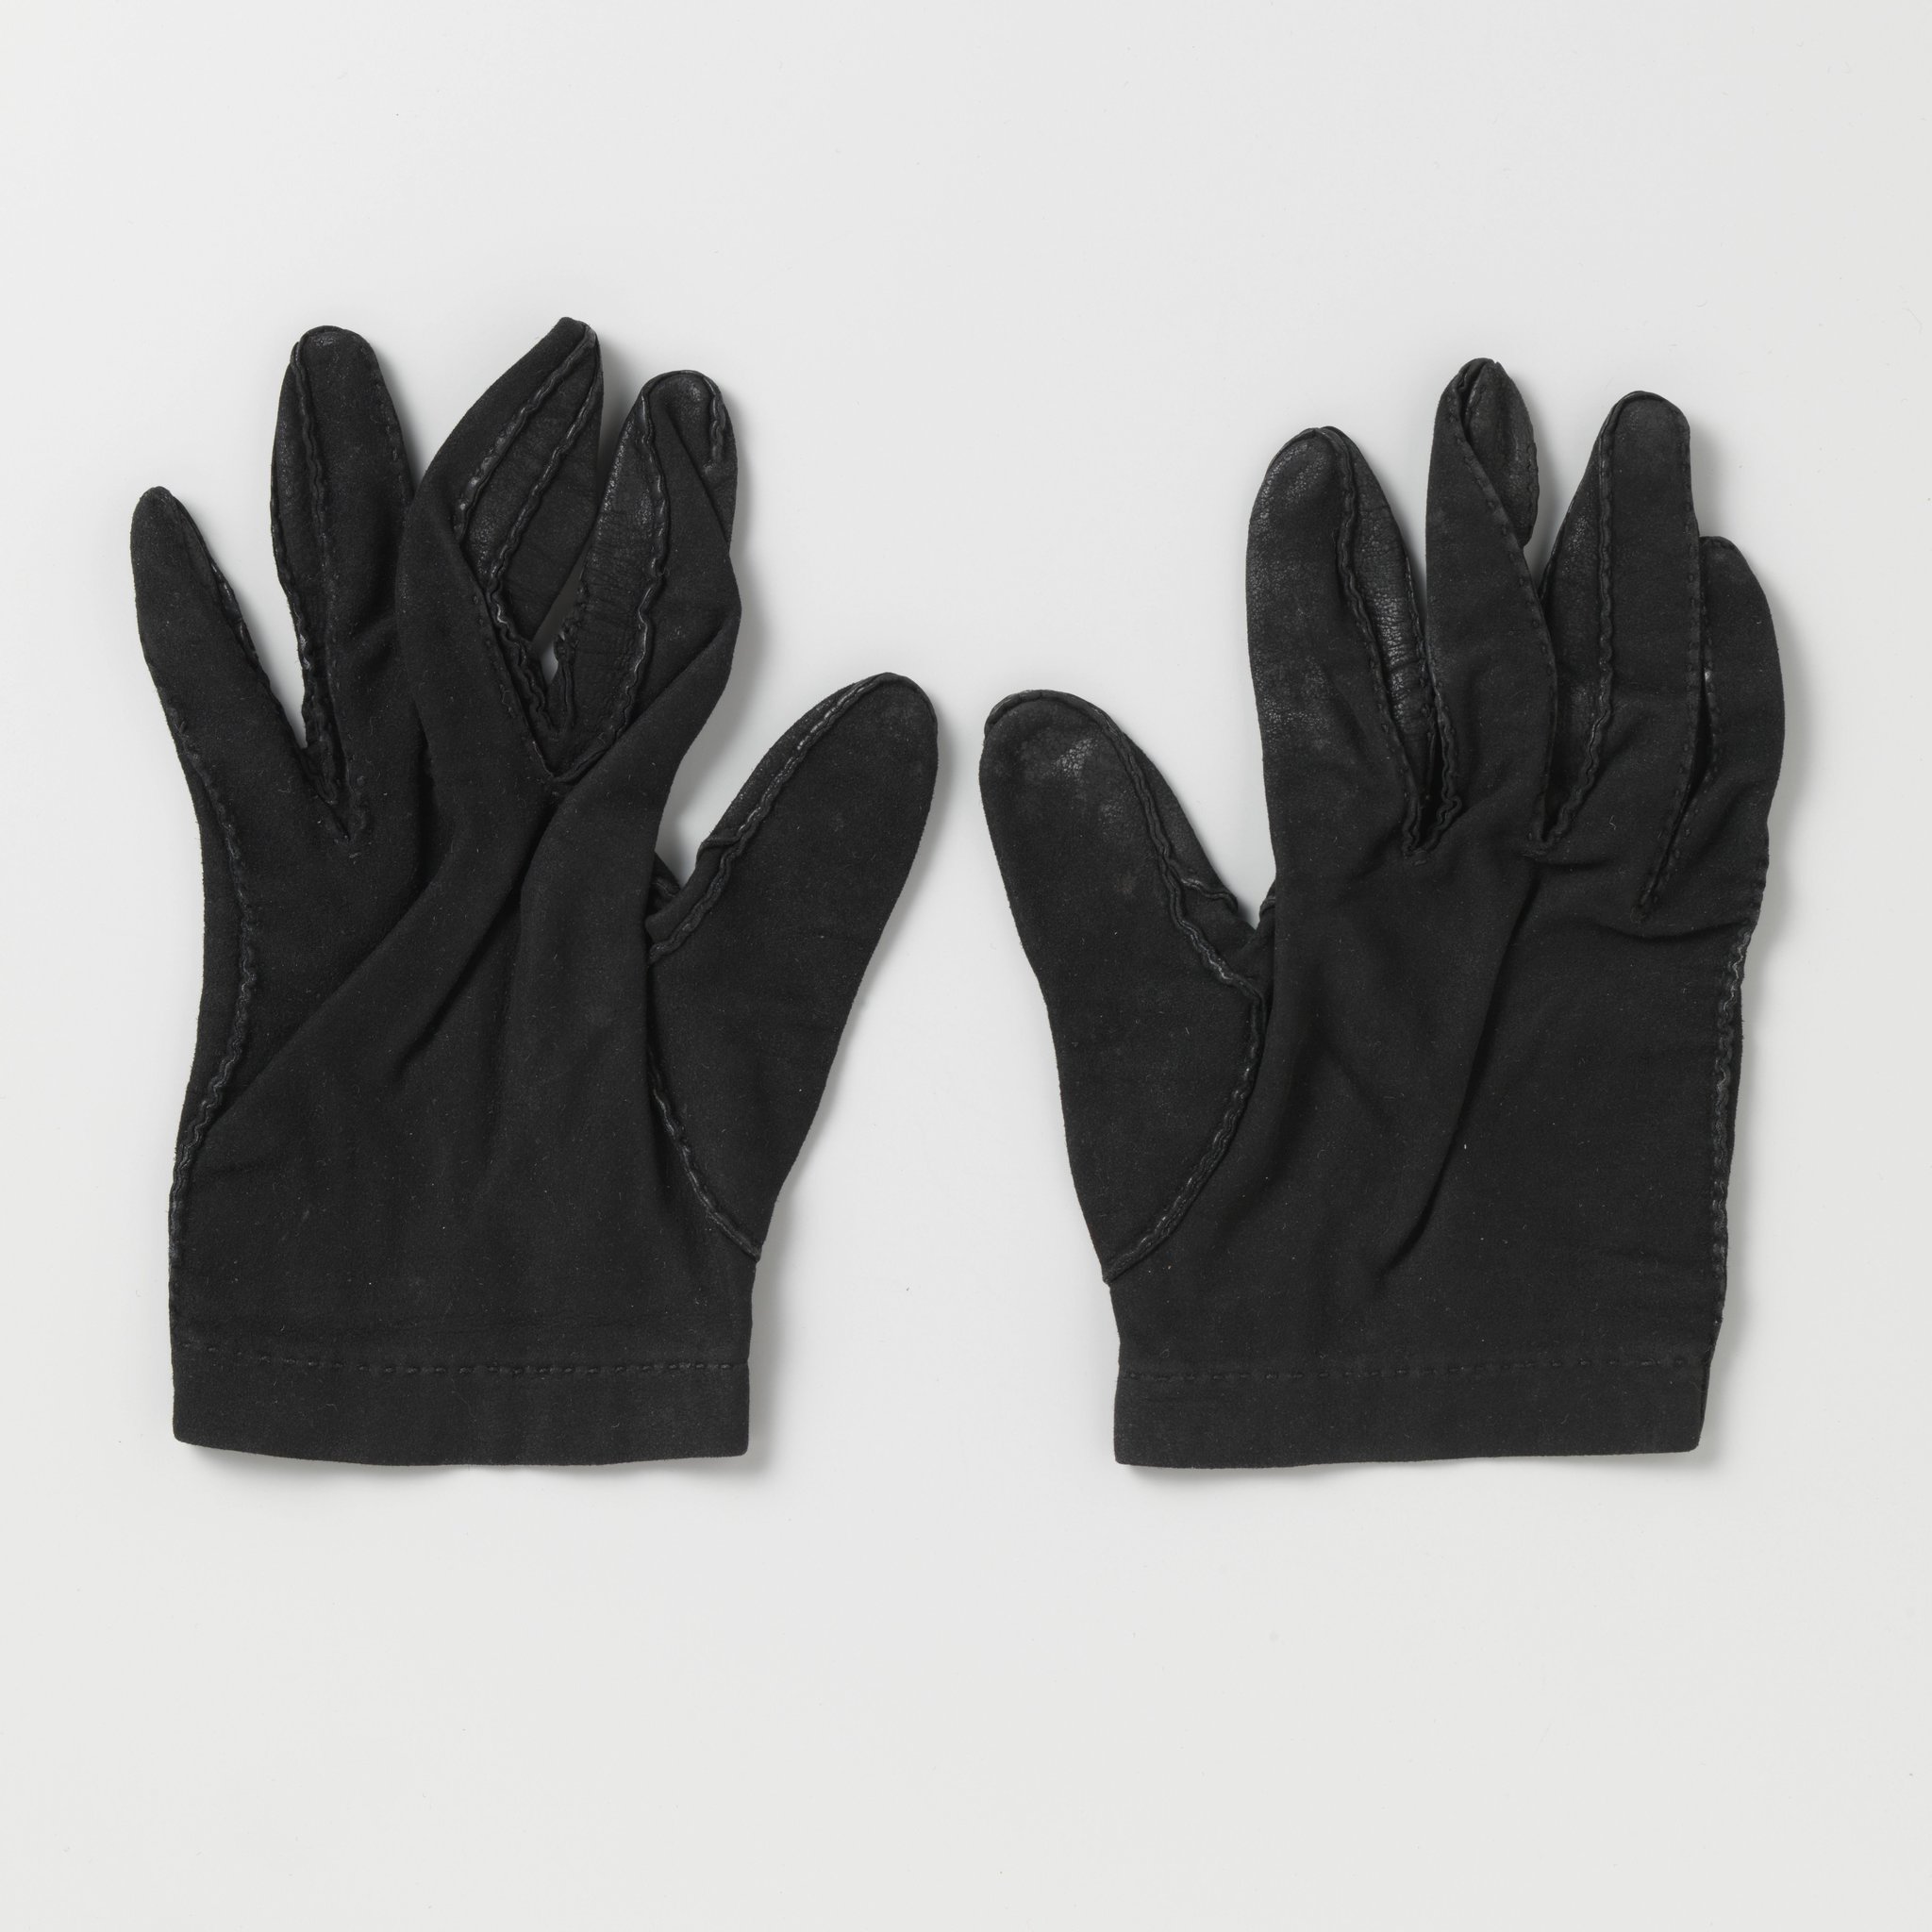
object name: glove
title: Rechterhandschoen van zwarte suède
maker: Anonymous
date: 1900-1915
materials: leather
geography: netherlands